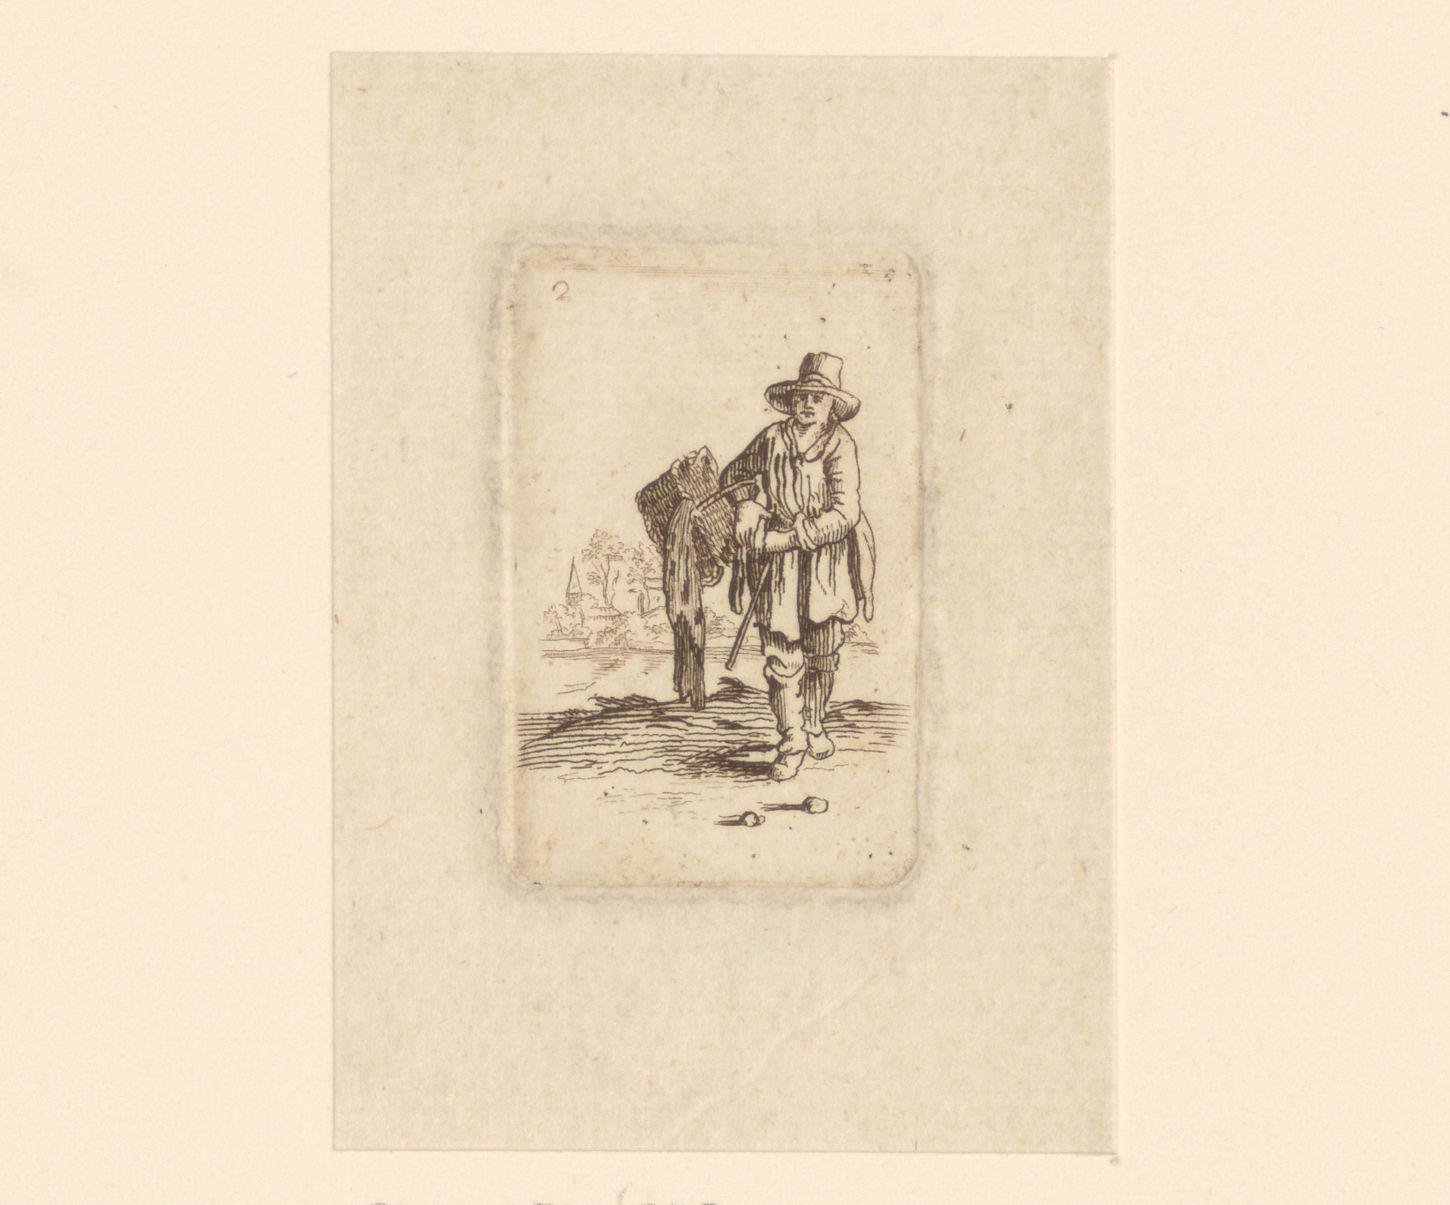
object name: print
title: Man met mand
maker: paul sandby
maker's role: draughtsman, print maker, publisher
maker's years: 1725-1809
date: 1735-1809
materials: paper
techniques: etching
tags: adult man, persons engaged in trade and commerce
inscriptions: collector's mark: Lugt 2228